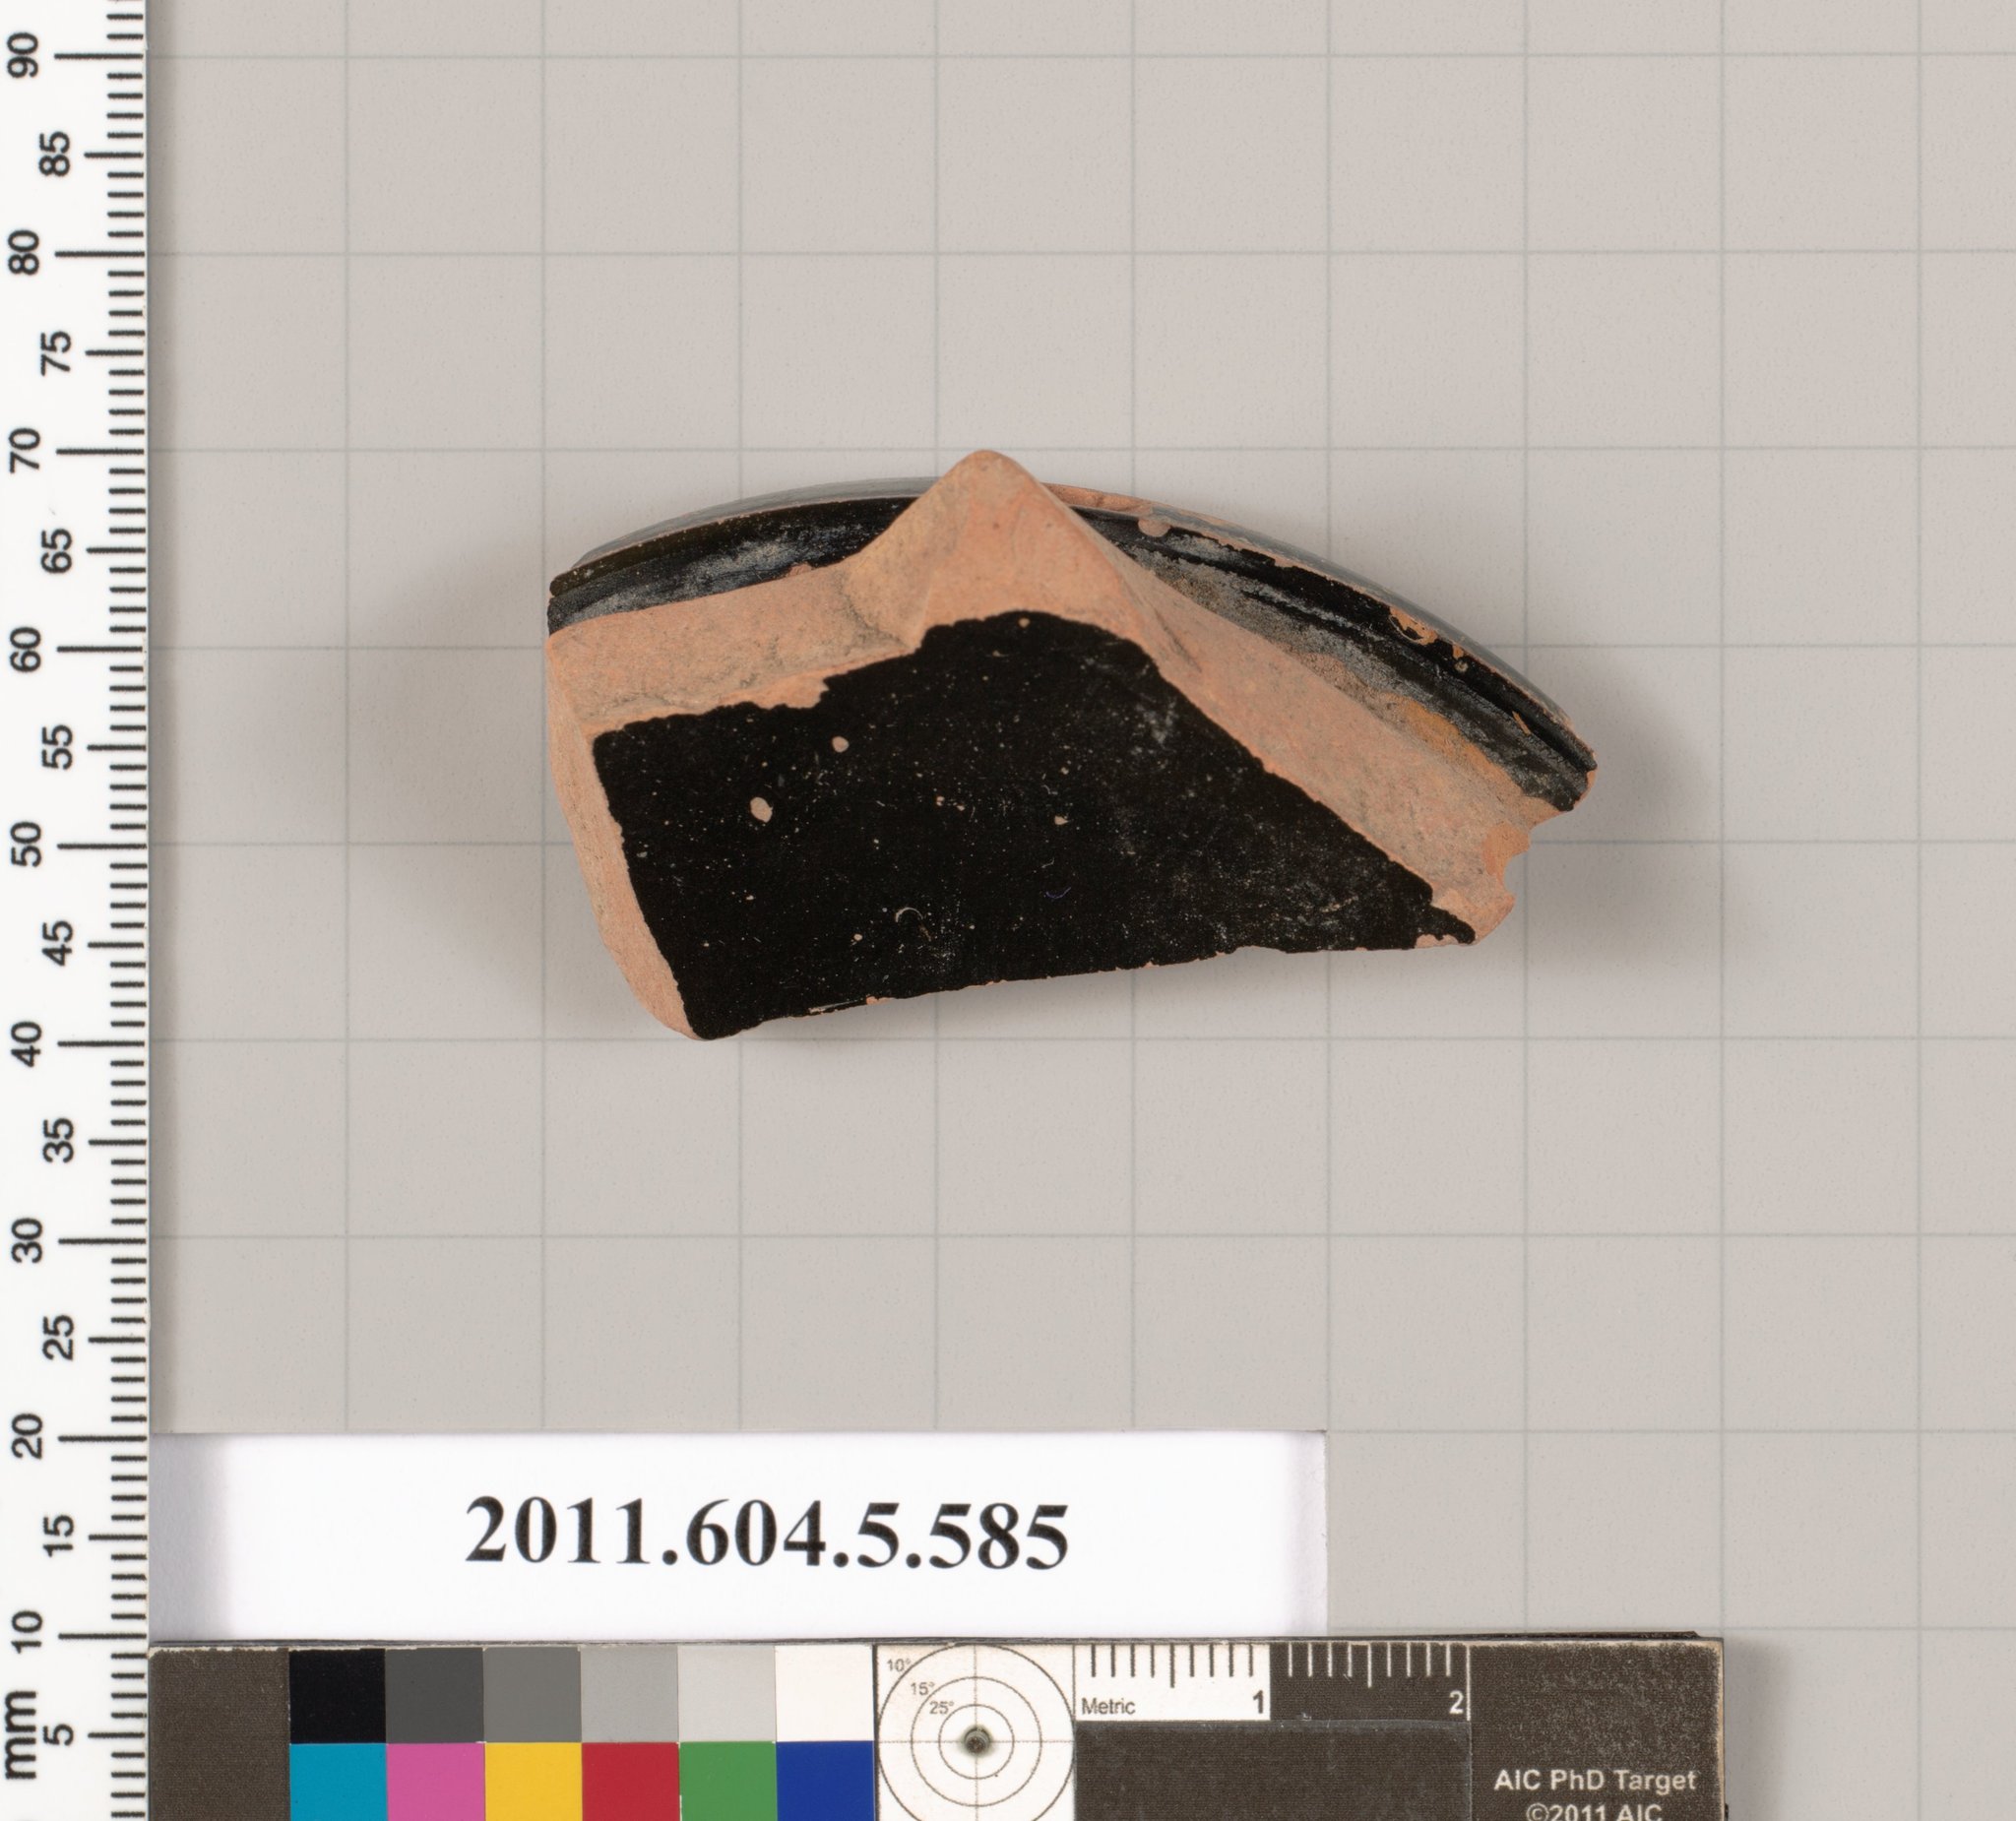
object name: stemless kylix fragment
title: Terracotta fragment of a stemless kylix (drinking cup)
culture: greek, attic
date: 600-401 BCE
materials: terracotta